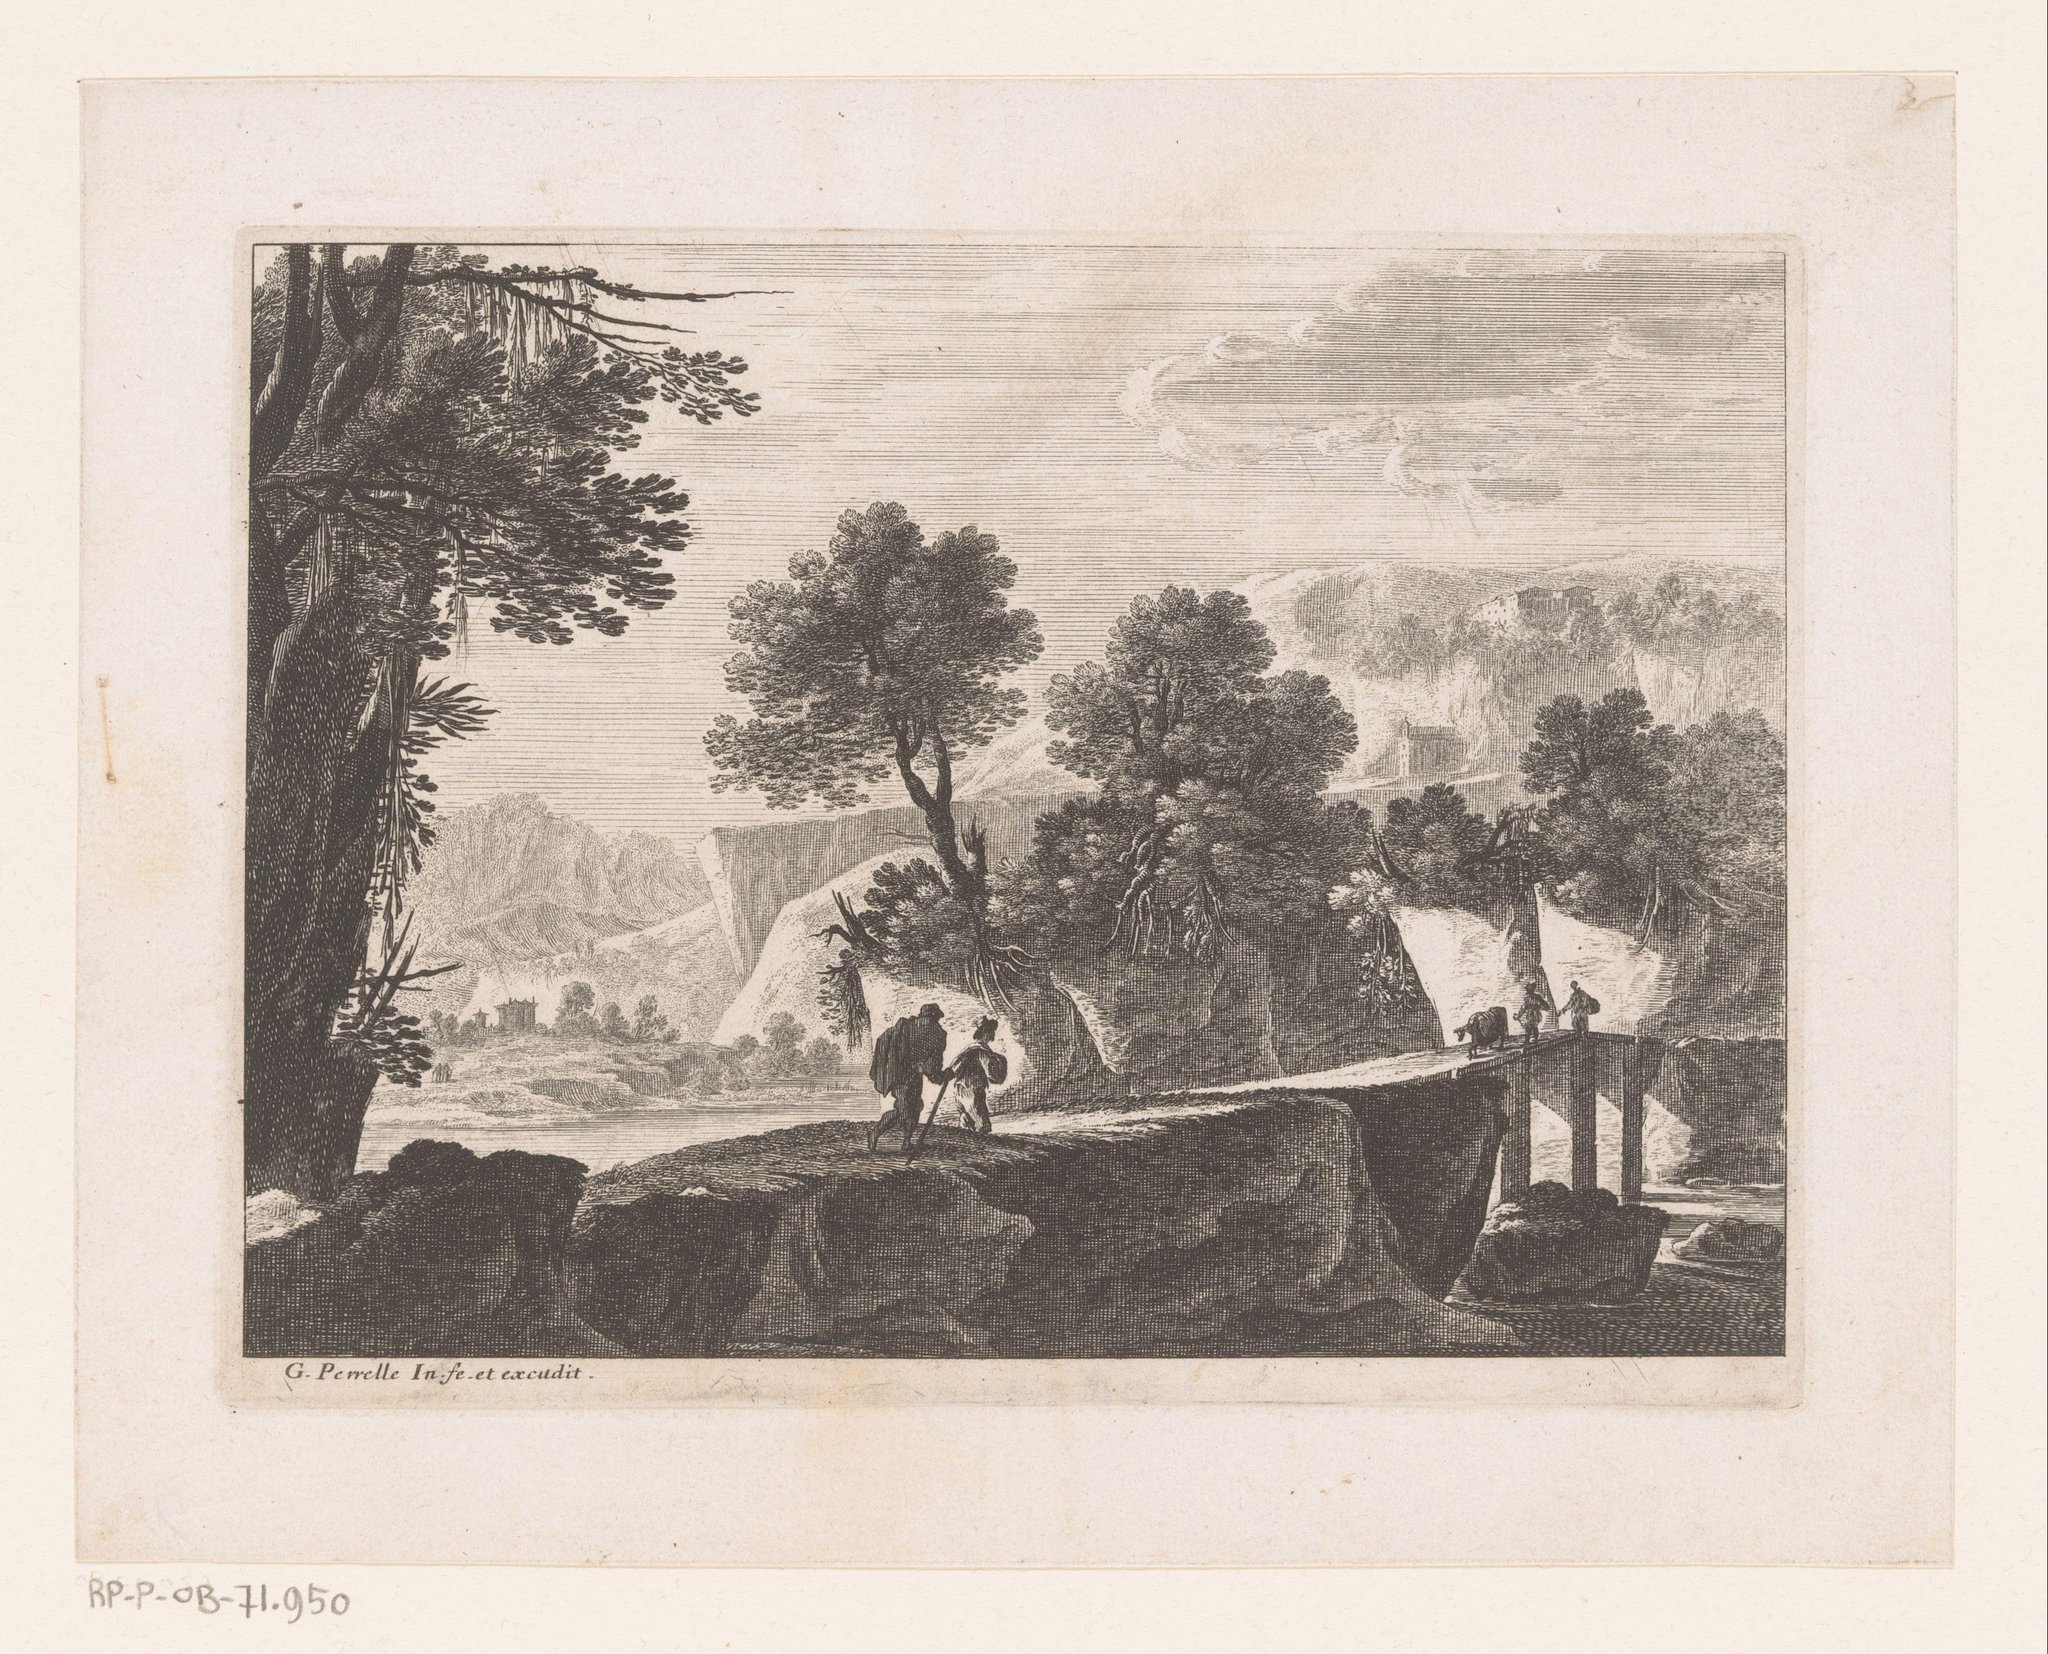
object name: print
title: Landschap met figuren op houten brug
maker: gabriel perelle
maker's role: draughtsman, print maker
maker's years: 1603-1677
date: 1613-1677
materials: paper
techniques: etching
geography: paris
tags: landscape with bridge, viaduct or aqueduct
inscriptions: collector's mark: Lugt 240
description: Prenten met het signatuur 'Perelle' kunnen zowel door vader Gabriel als door zonen Nicolas en Adam gemaakt zijn.